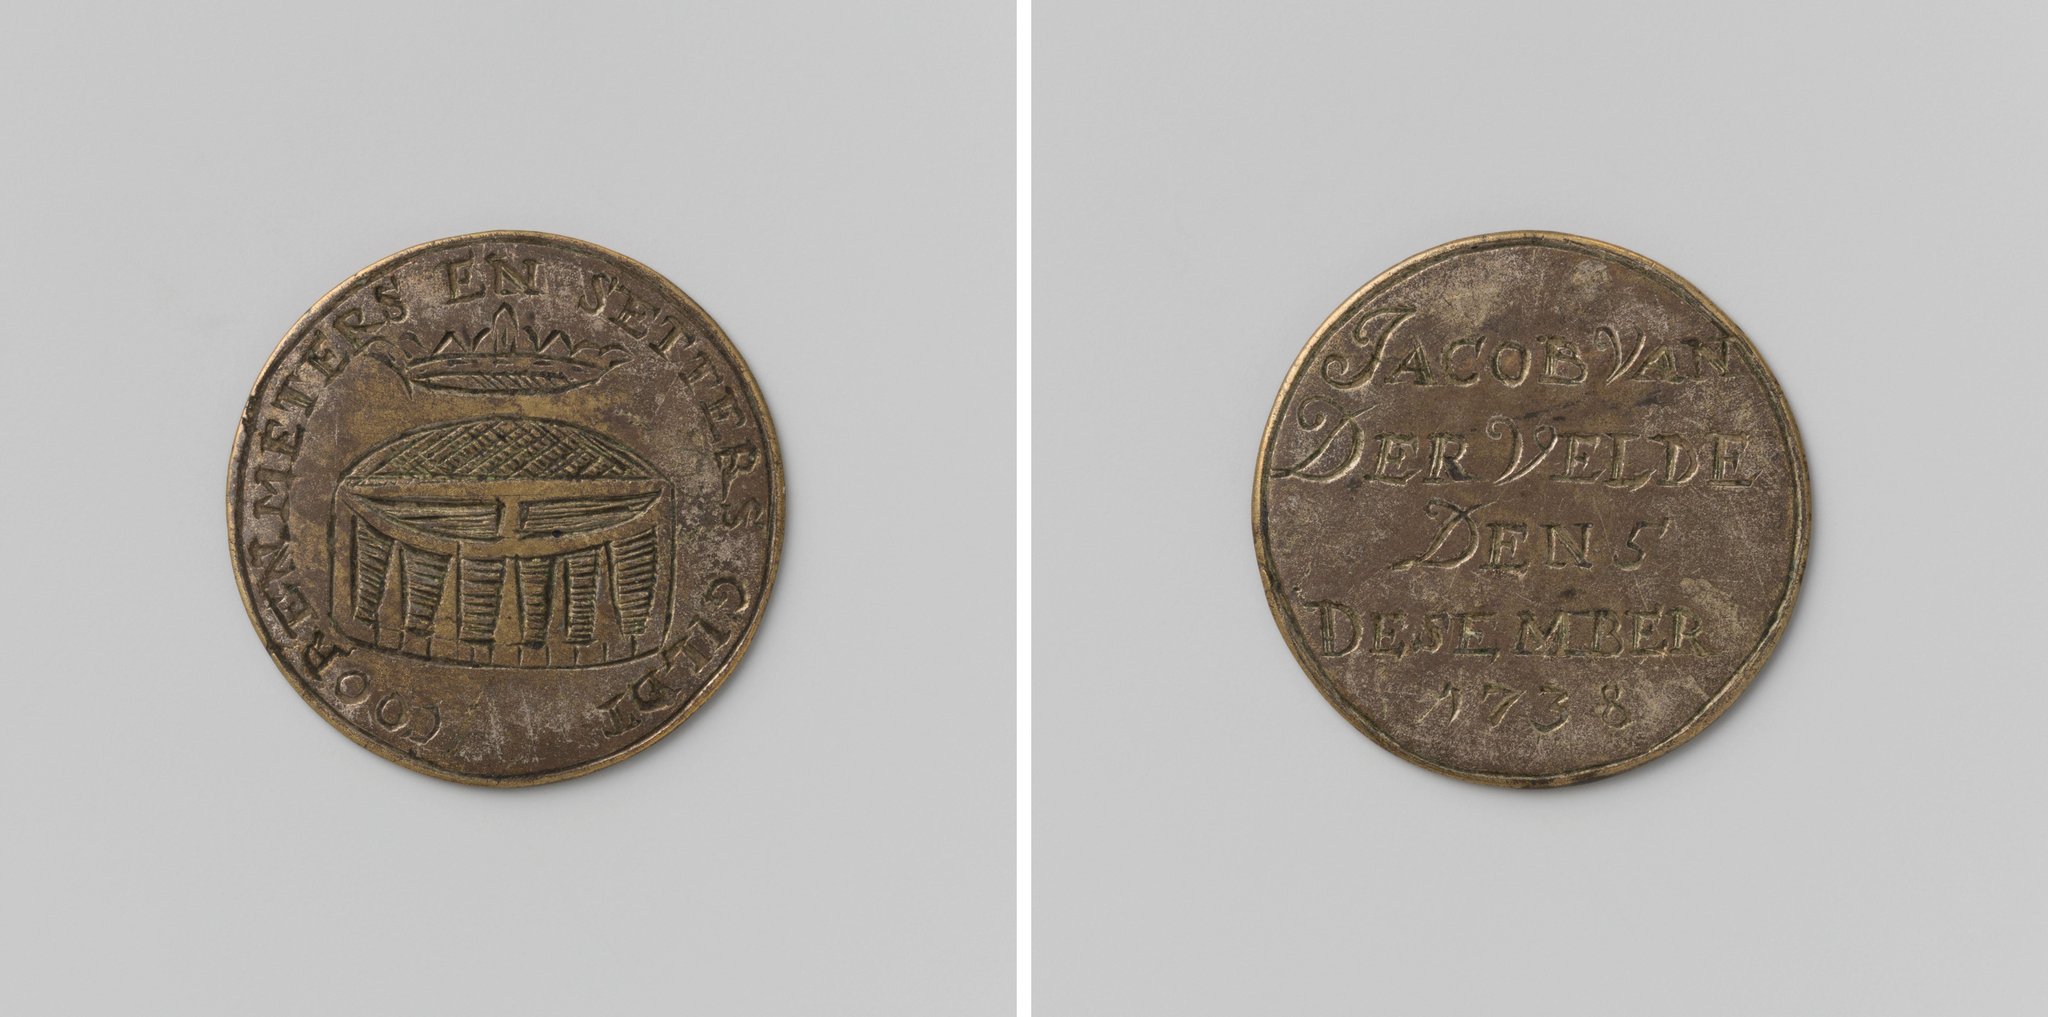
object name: medal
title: Korenmeters- en -zettersgilde van Amsterdam, gildepenning van Jacob van der Velde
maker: Anonymous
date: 1738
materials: copper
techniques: engraving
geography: amsterdam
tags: amsterdam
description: Koperen penning. Voorzijde: gekroonde korenmaat binnen omschrift. Keerzijde: opschrift